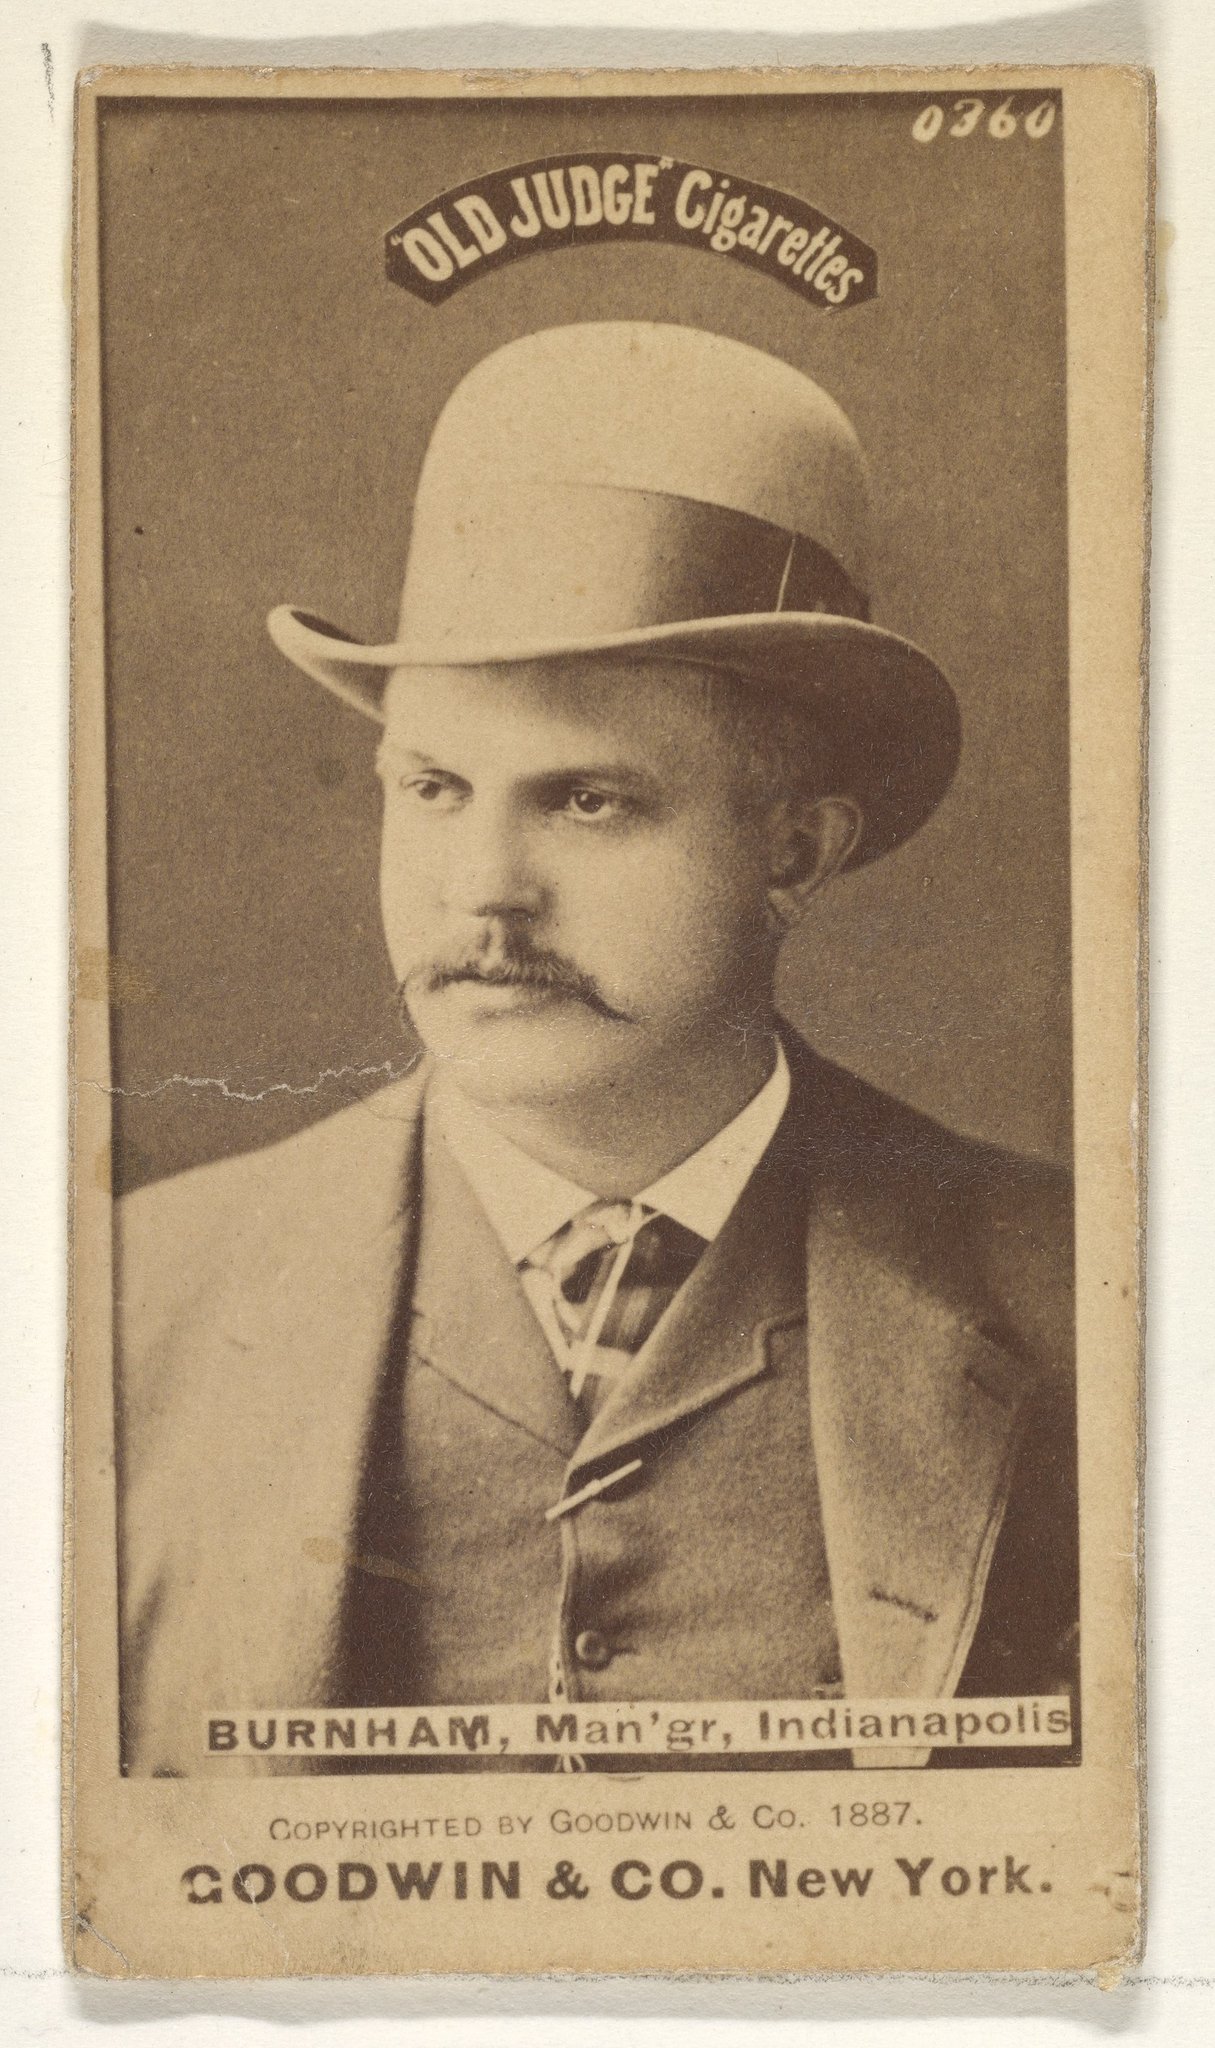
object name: baseball card, photograph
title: Burnham, Manager, Indianapolis, from the Old Judge series (N172) for Old Judge Cigarettes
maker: goodwin & company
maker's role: publisher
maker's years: 1850-1950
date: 1887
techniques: albumen silver print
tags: men,portraits